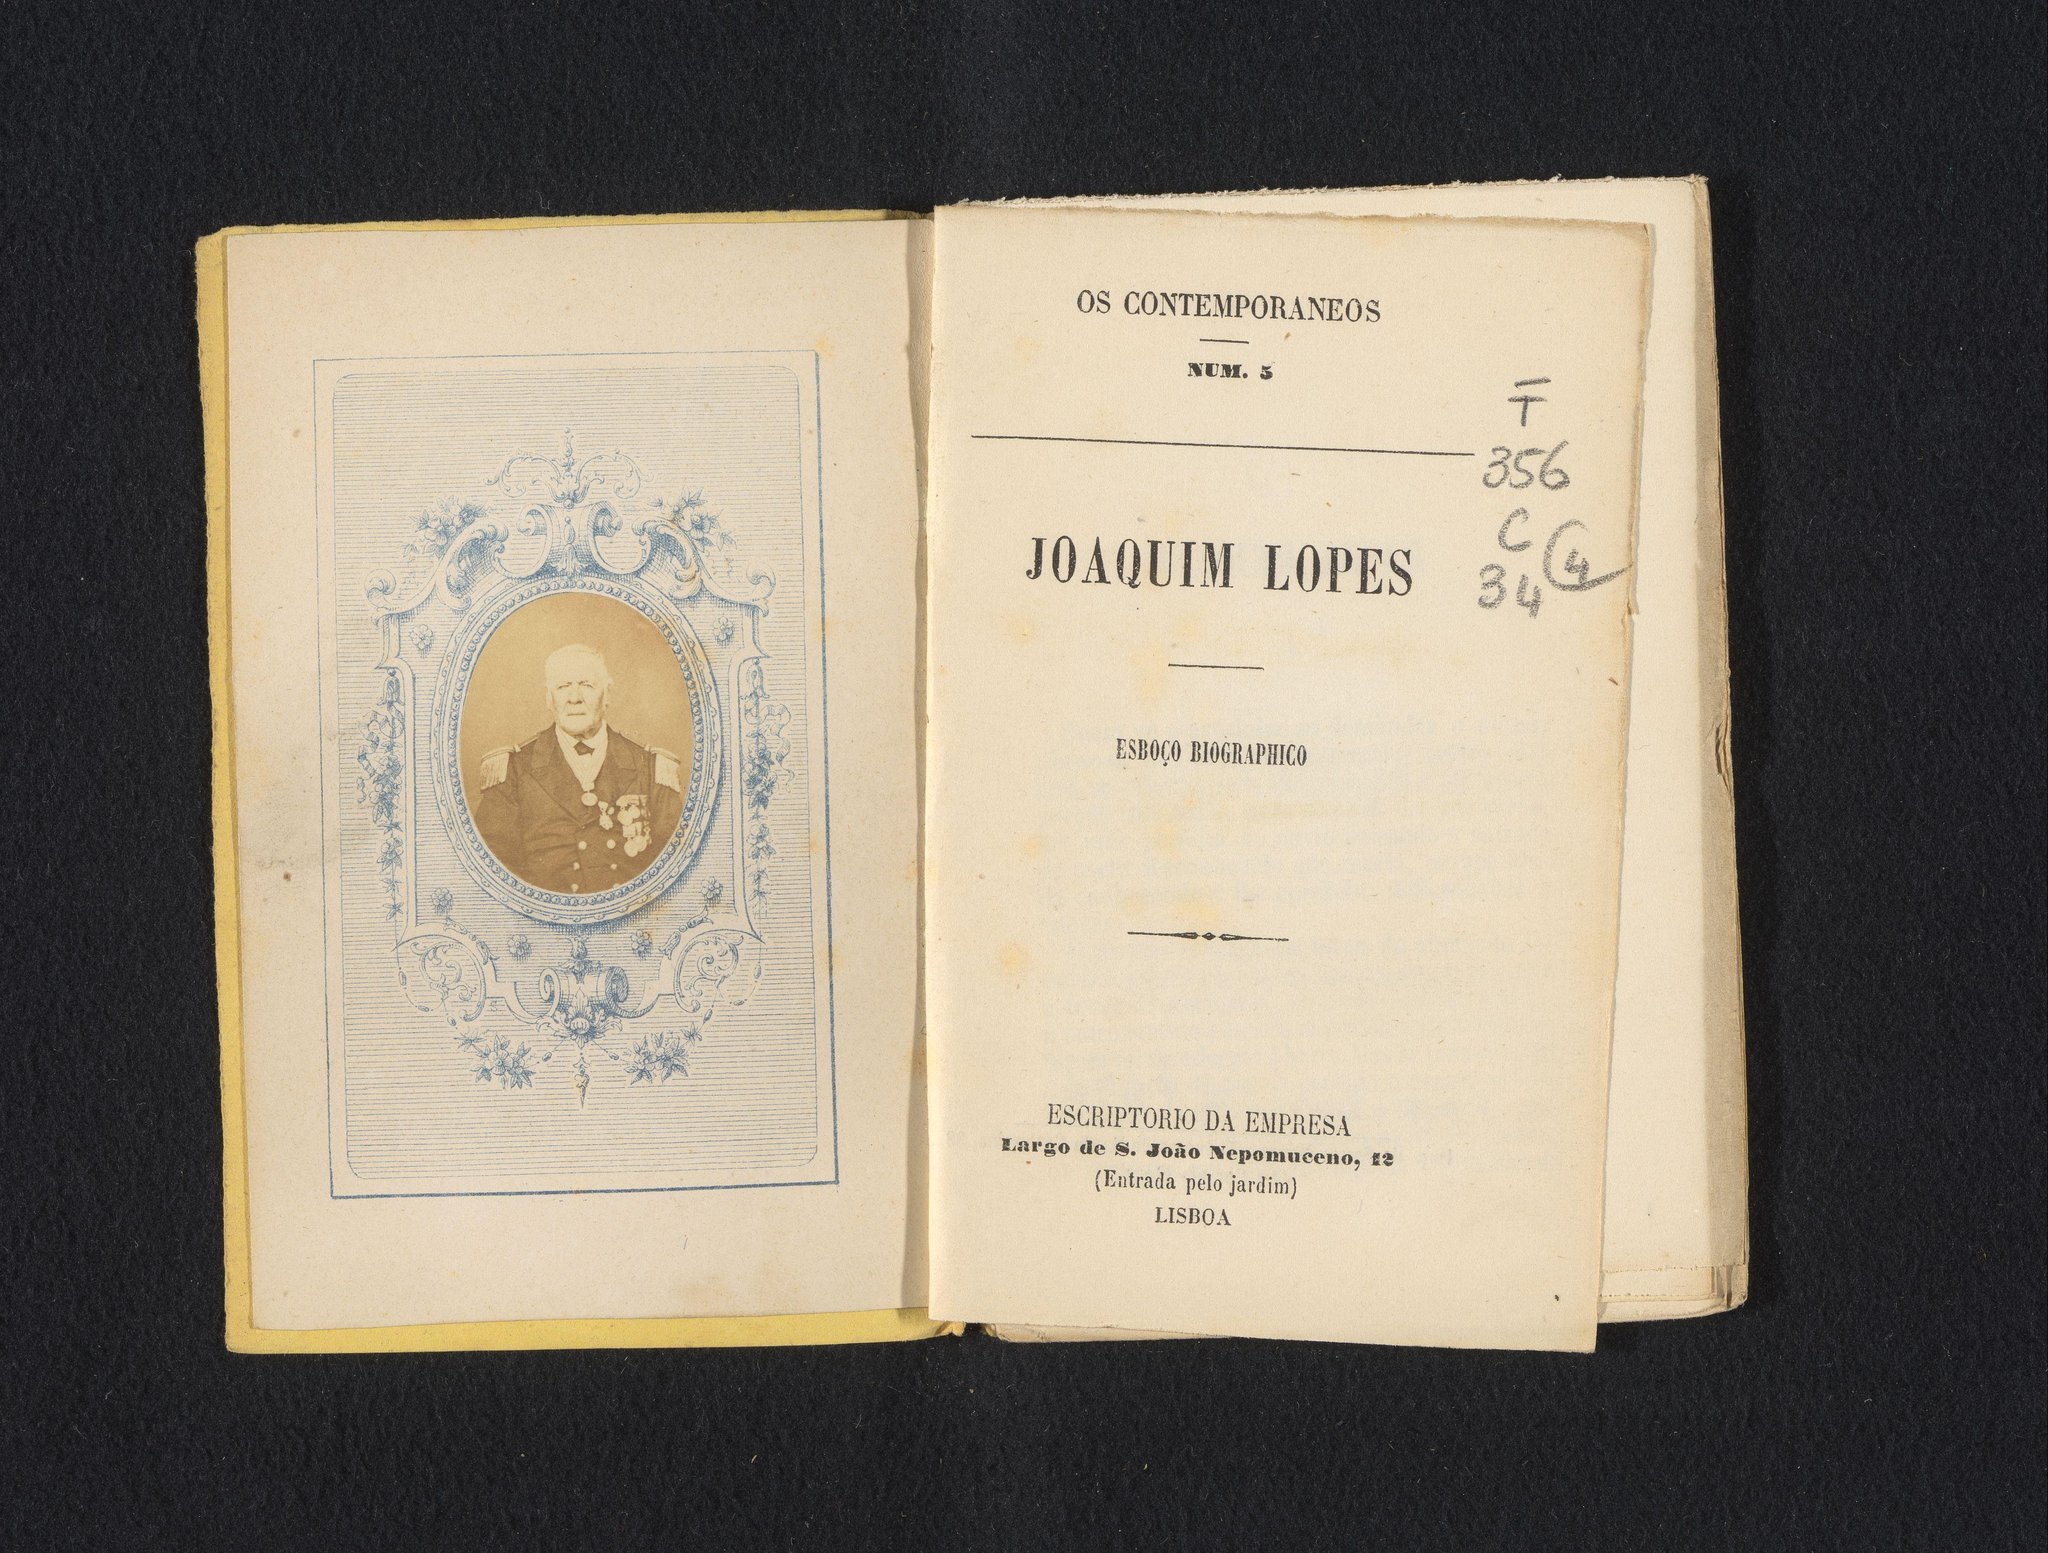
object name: photograph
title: Portret van Joaquim Lopes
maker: Anonymous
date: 1873-1878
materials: photographic support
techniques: albumen print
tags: historical persons